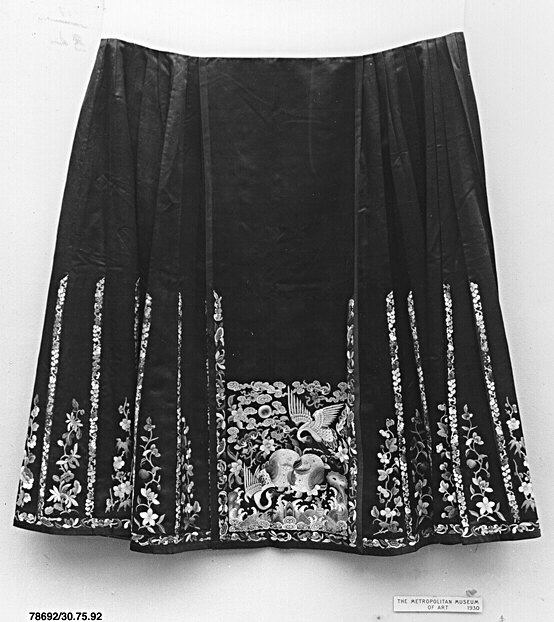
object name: skirt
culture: chinese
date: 1701-1800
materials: metal thread, silk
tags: birds